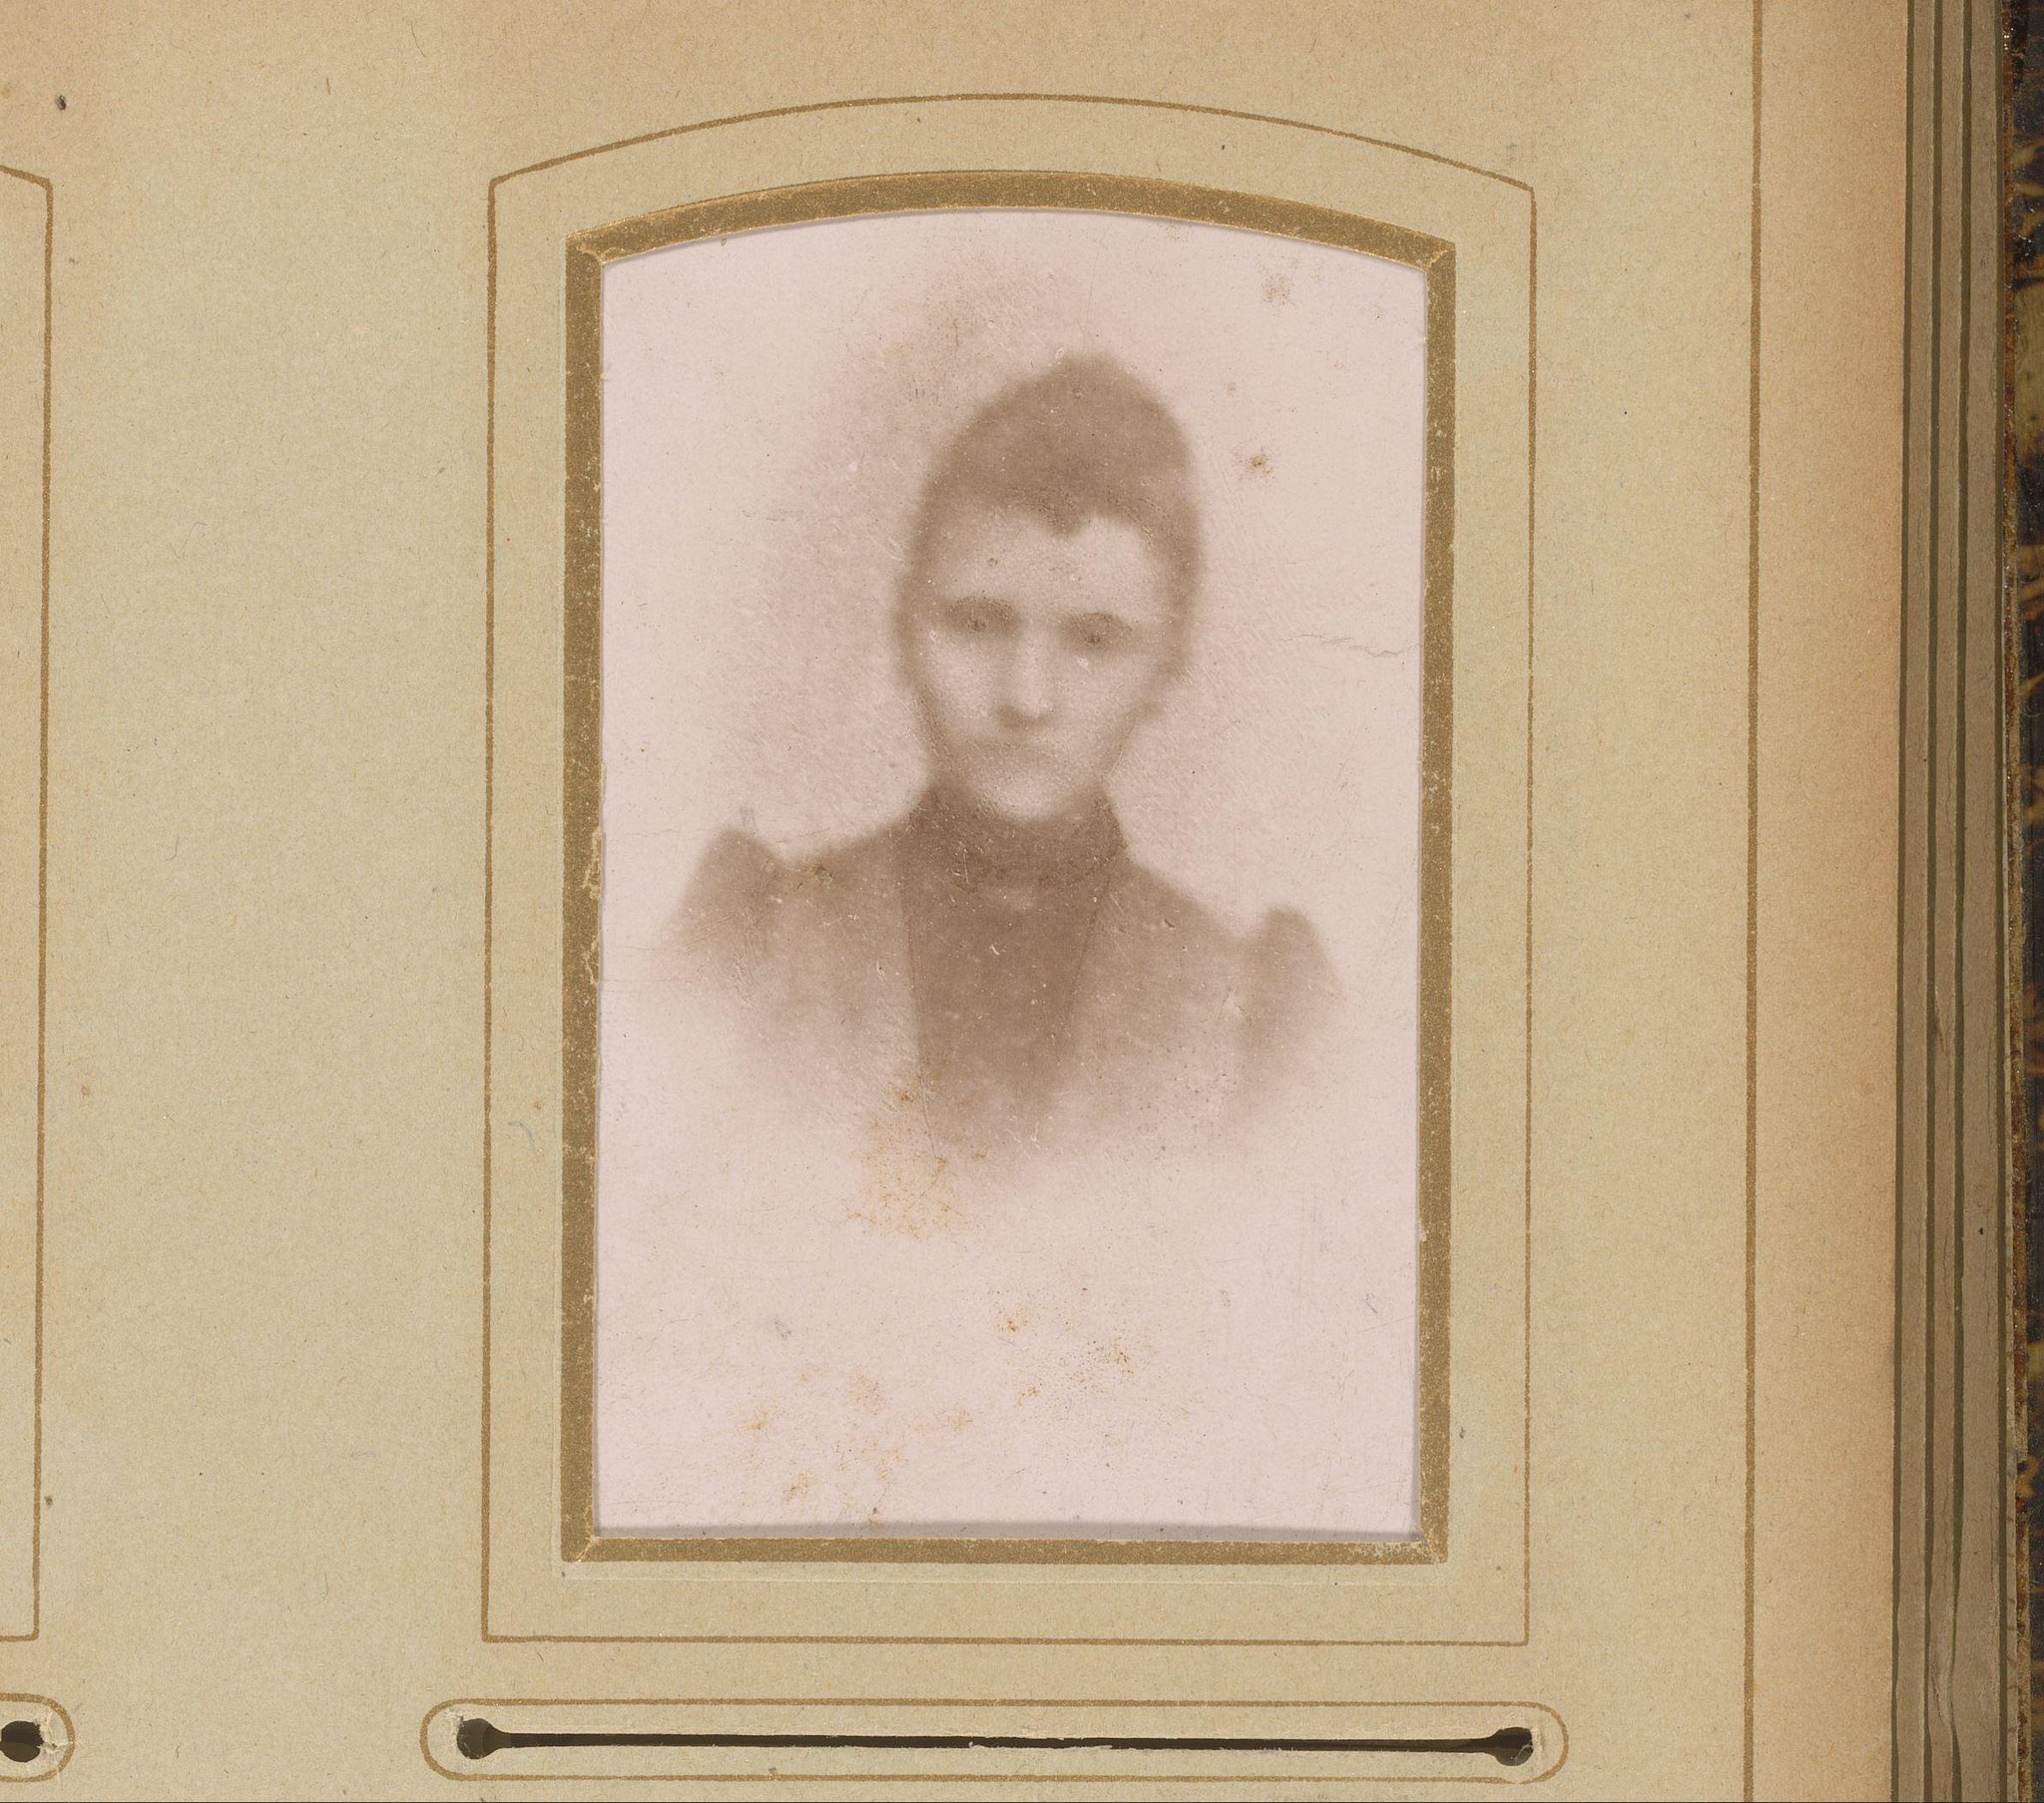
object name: album leaf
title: Portret van een jonge vrouw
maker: lieven gevaert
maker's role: fotograaf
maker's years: 1868-1935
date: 1889-1894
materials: cardboard, photographic support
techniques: collodion silver print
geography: antwerp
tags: adolescent, young woman, maiden, historical persons - bb - woman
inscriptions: inscription: ‘L. GEVAERT/ [FO]TOGRAAF/ [MONTIGN]YSTRAAT, 159/ ANTWERPEN’